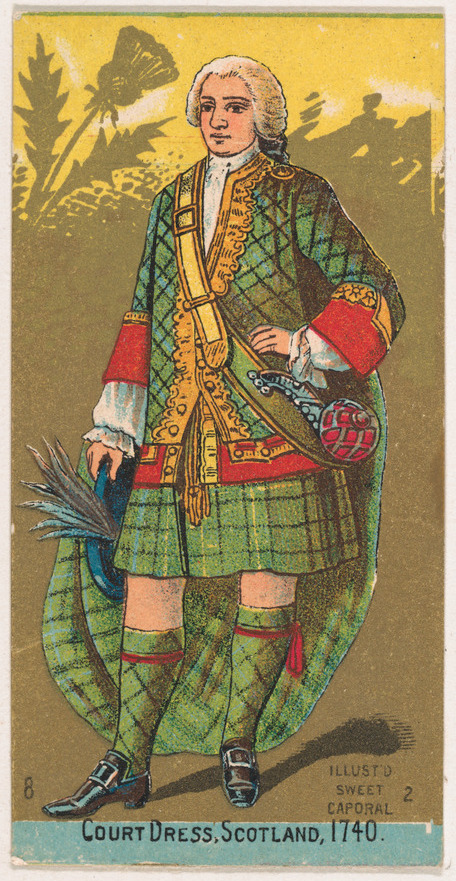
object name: print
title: Count Dress, Scotland, 1740, from the Military Series (N224) issued by Kinney Tobacco Company to promote Sweet Caporal Cigarettes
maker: kinney brothers tobacco company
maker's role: publisher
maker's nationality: american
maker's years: 1869-2011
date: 1888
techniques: color lithograph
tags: military clothing,men